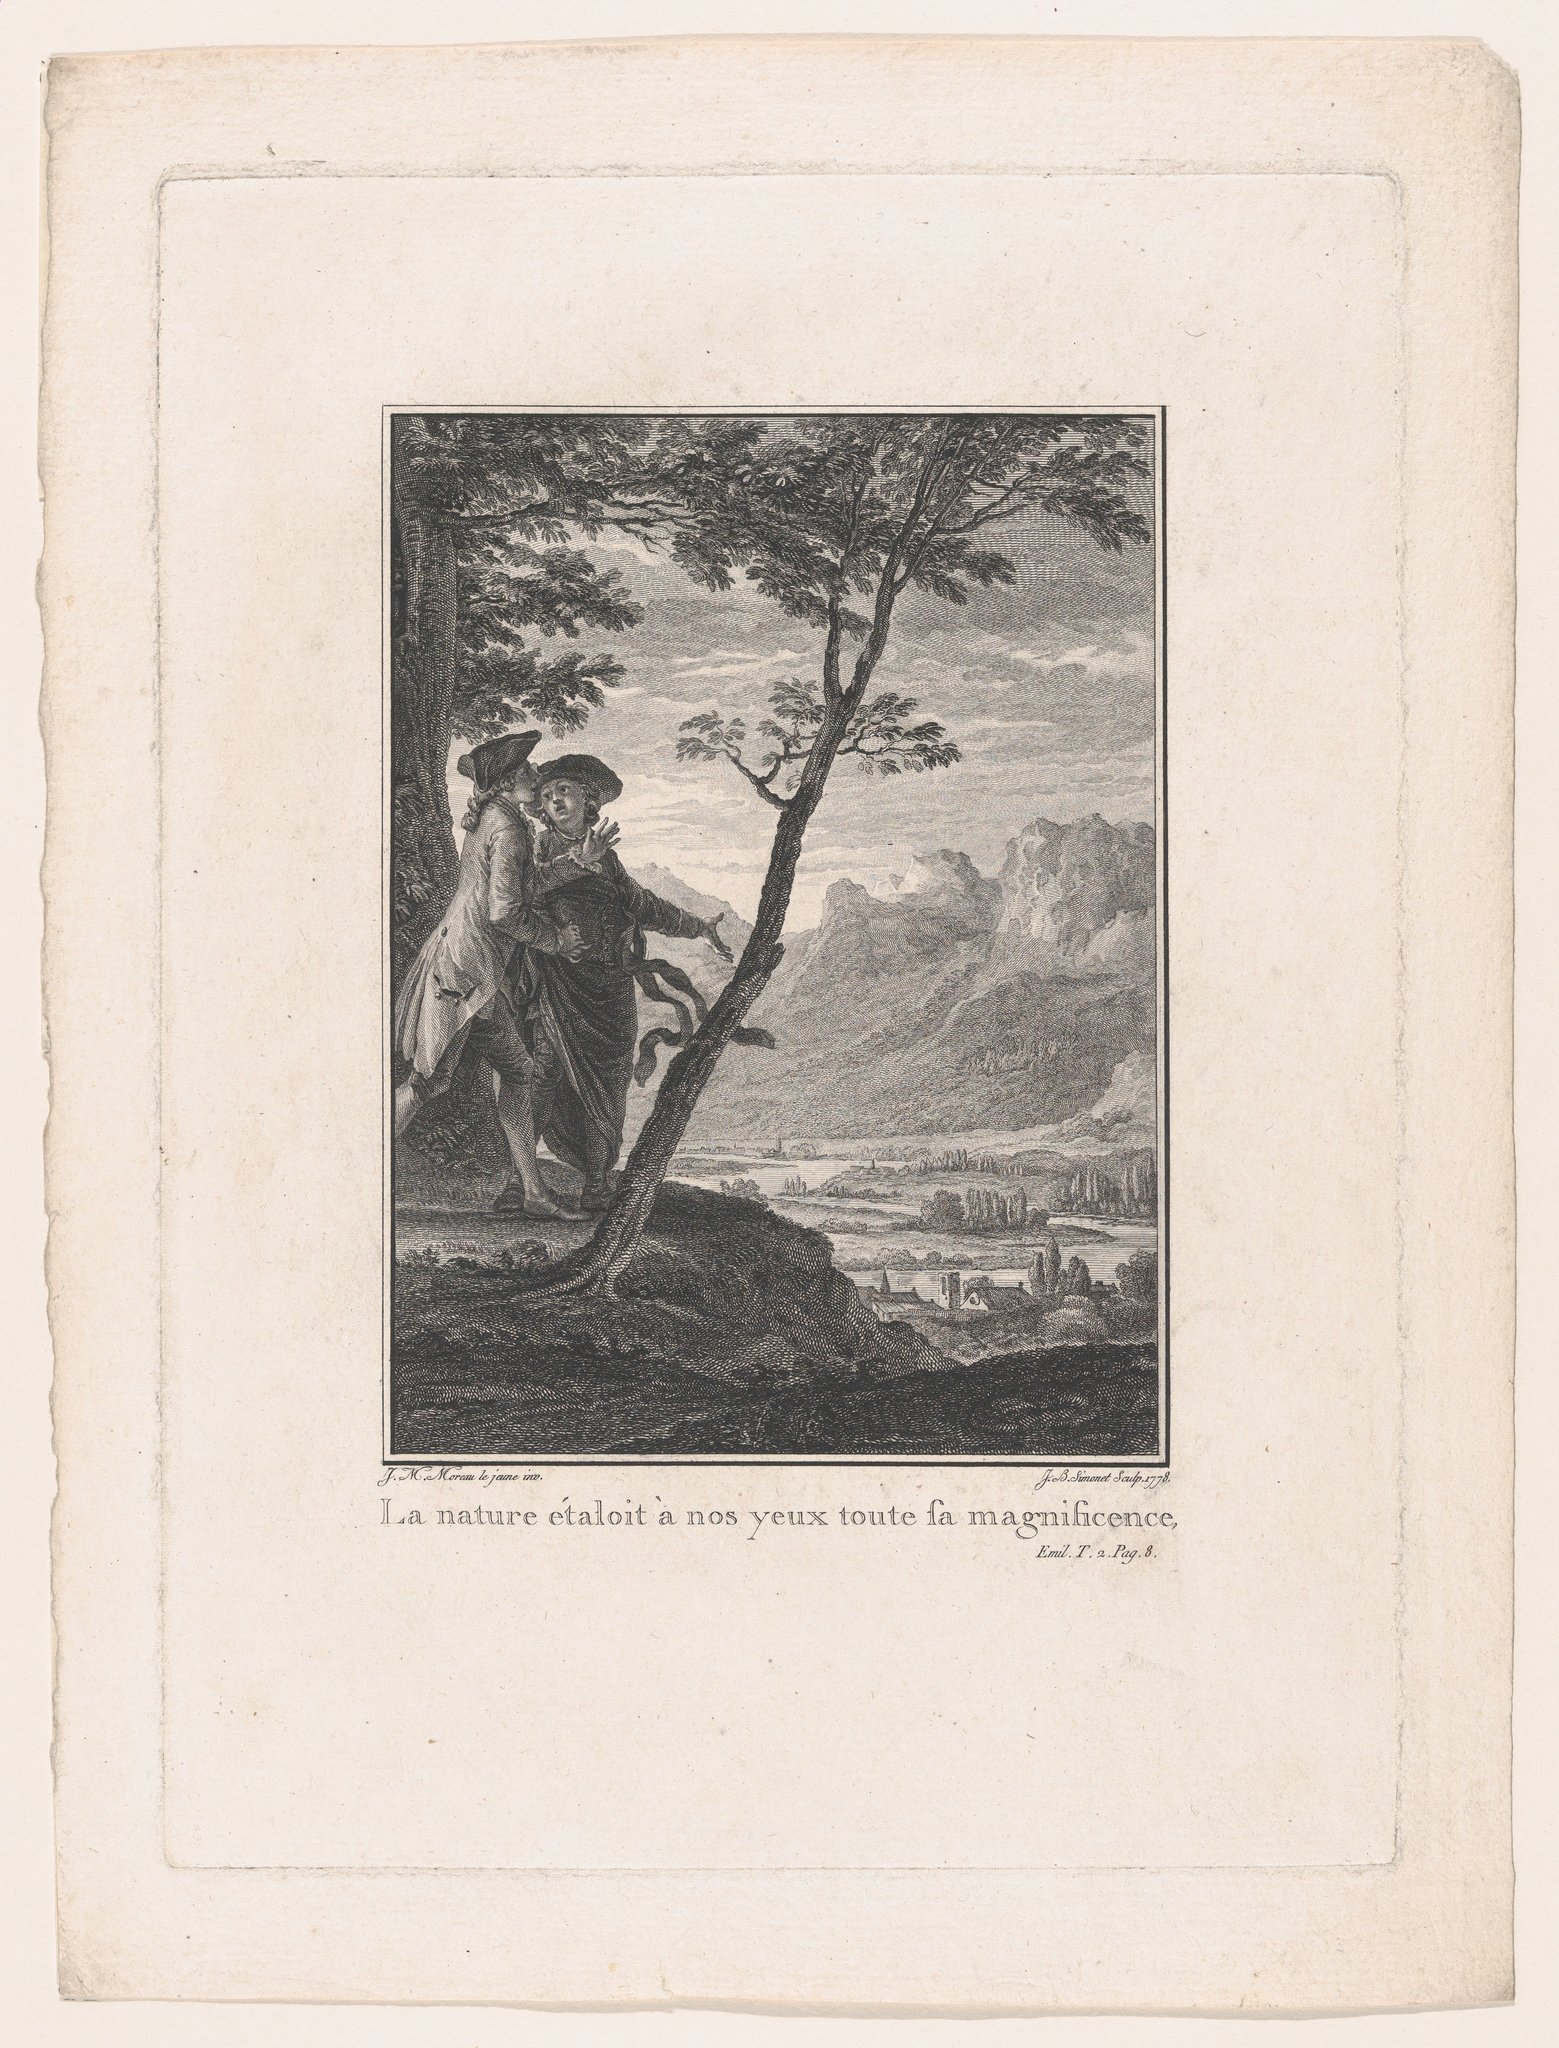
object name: print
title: Vignette on page 8 of Volume IV, from the 1774 Edition of Emile ou de l'Education par J.-J. Rousseau Citoyen de Genèvre, part of Collection Complette des oeuvres de J. J. Rousseau, Londres. 1774.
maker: jean-baptiste-blaise simonet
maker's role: artist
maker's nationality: french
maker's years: 1742-1842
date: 1778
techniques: engraving, etching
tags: men,trees